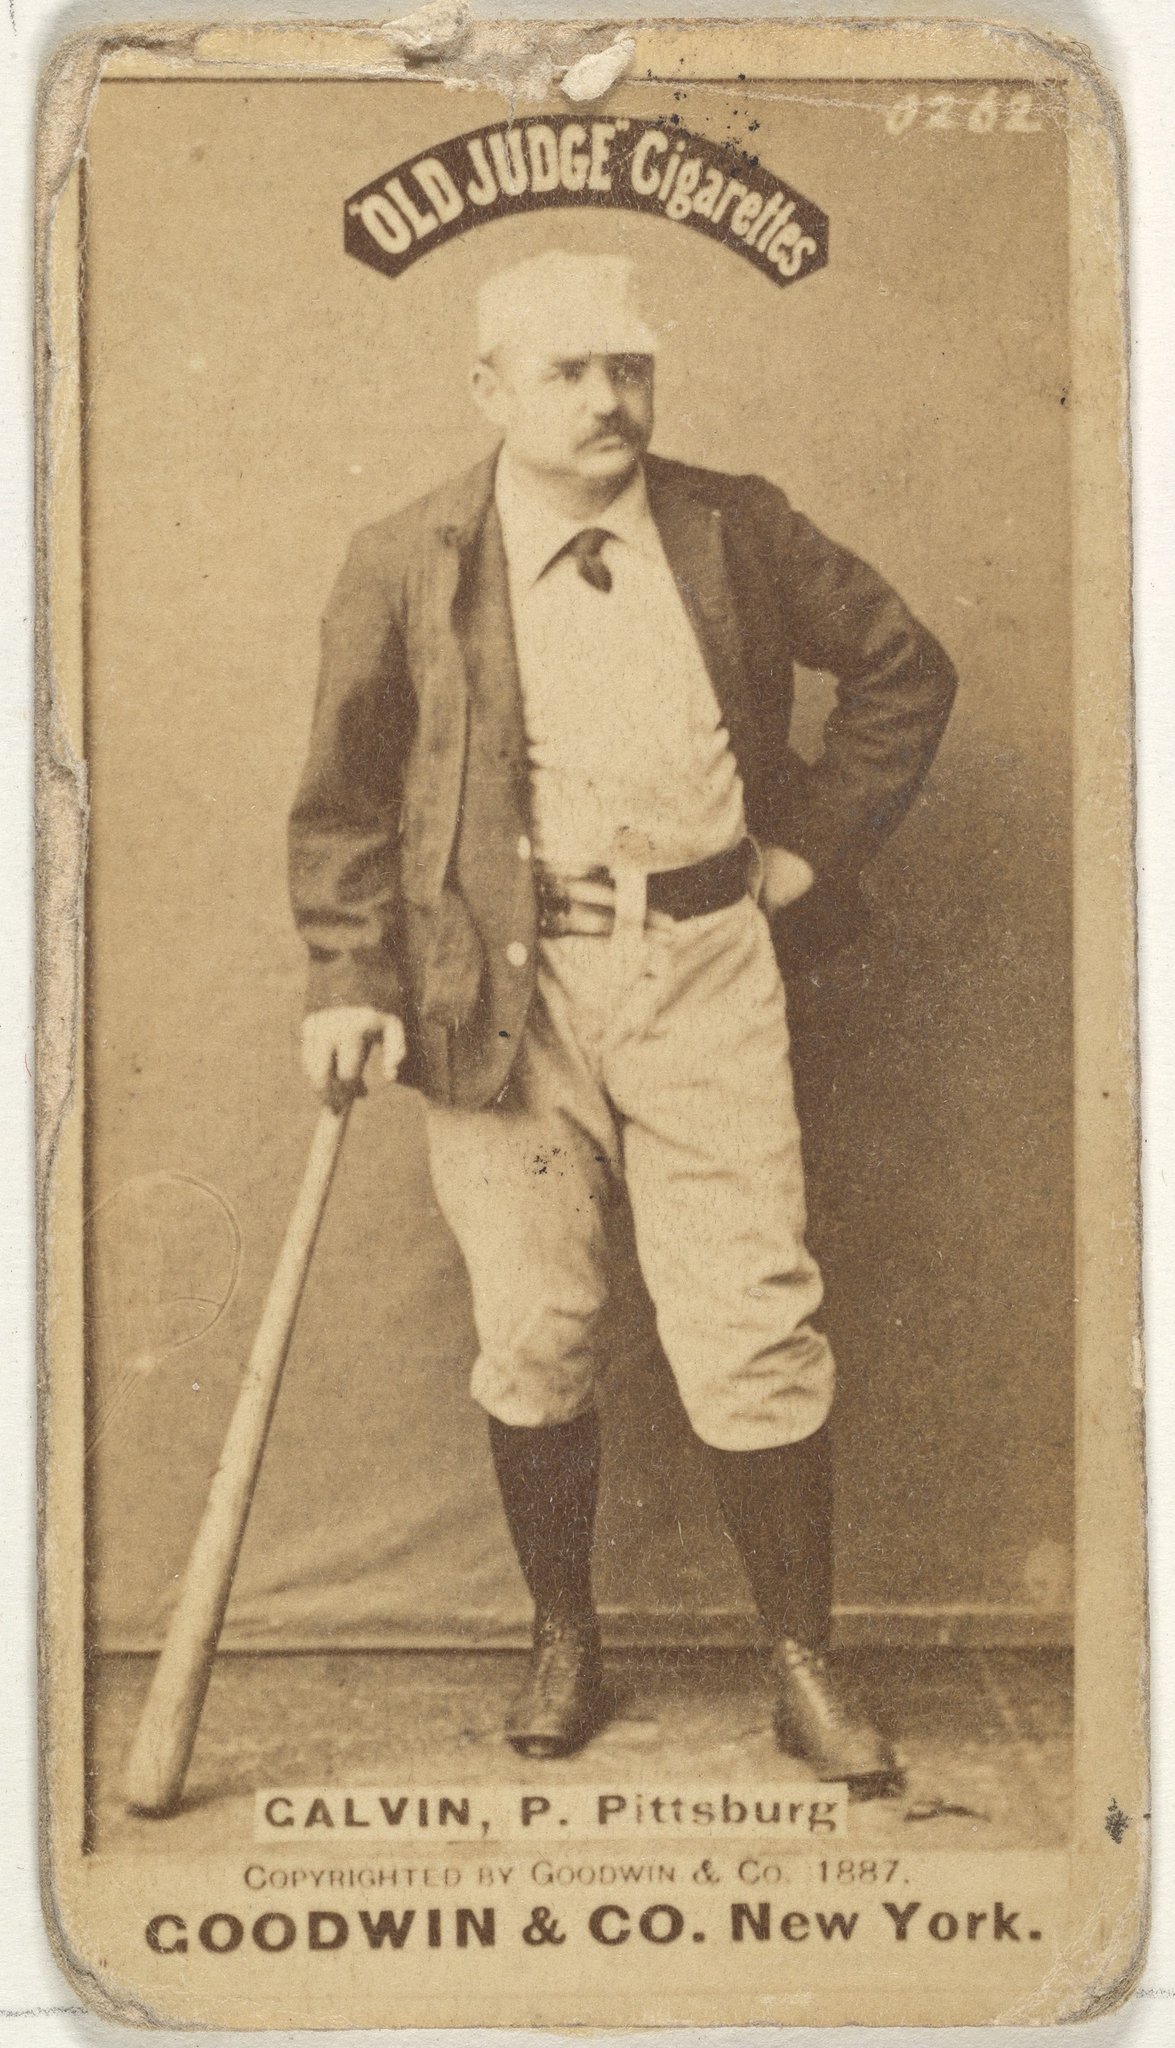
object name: baseball card, photograph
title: James Francis "Pud" Galvin, Pitcher, Pittsburgh, from the Old Judge series (N172) for Old Judge Cigarettes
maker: goodwin & company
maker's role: publisher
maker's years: 1850-1950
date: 1887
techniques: albumen silver print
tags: men,portraits,baseball,athletes